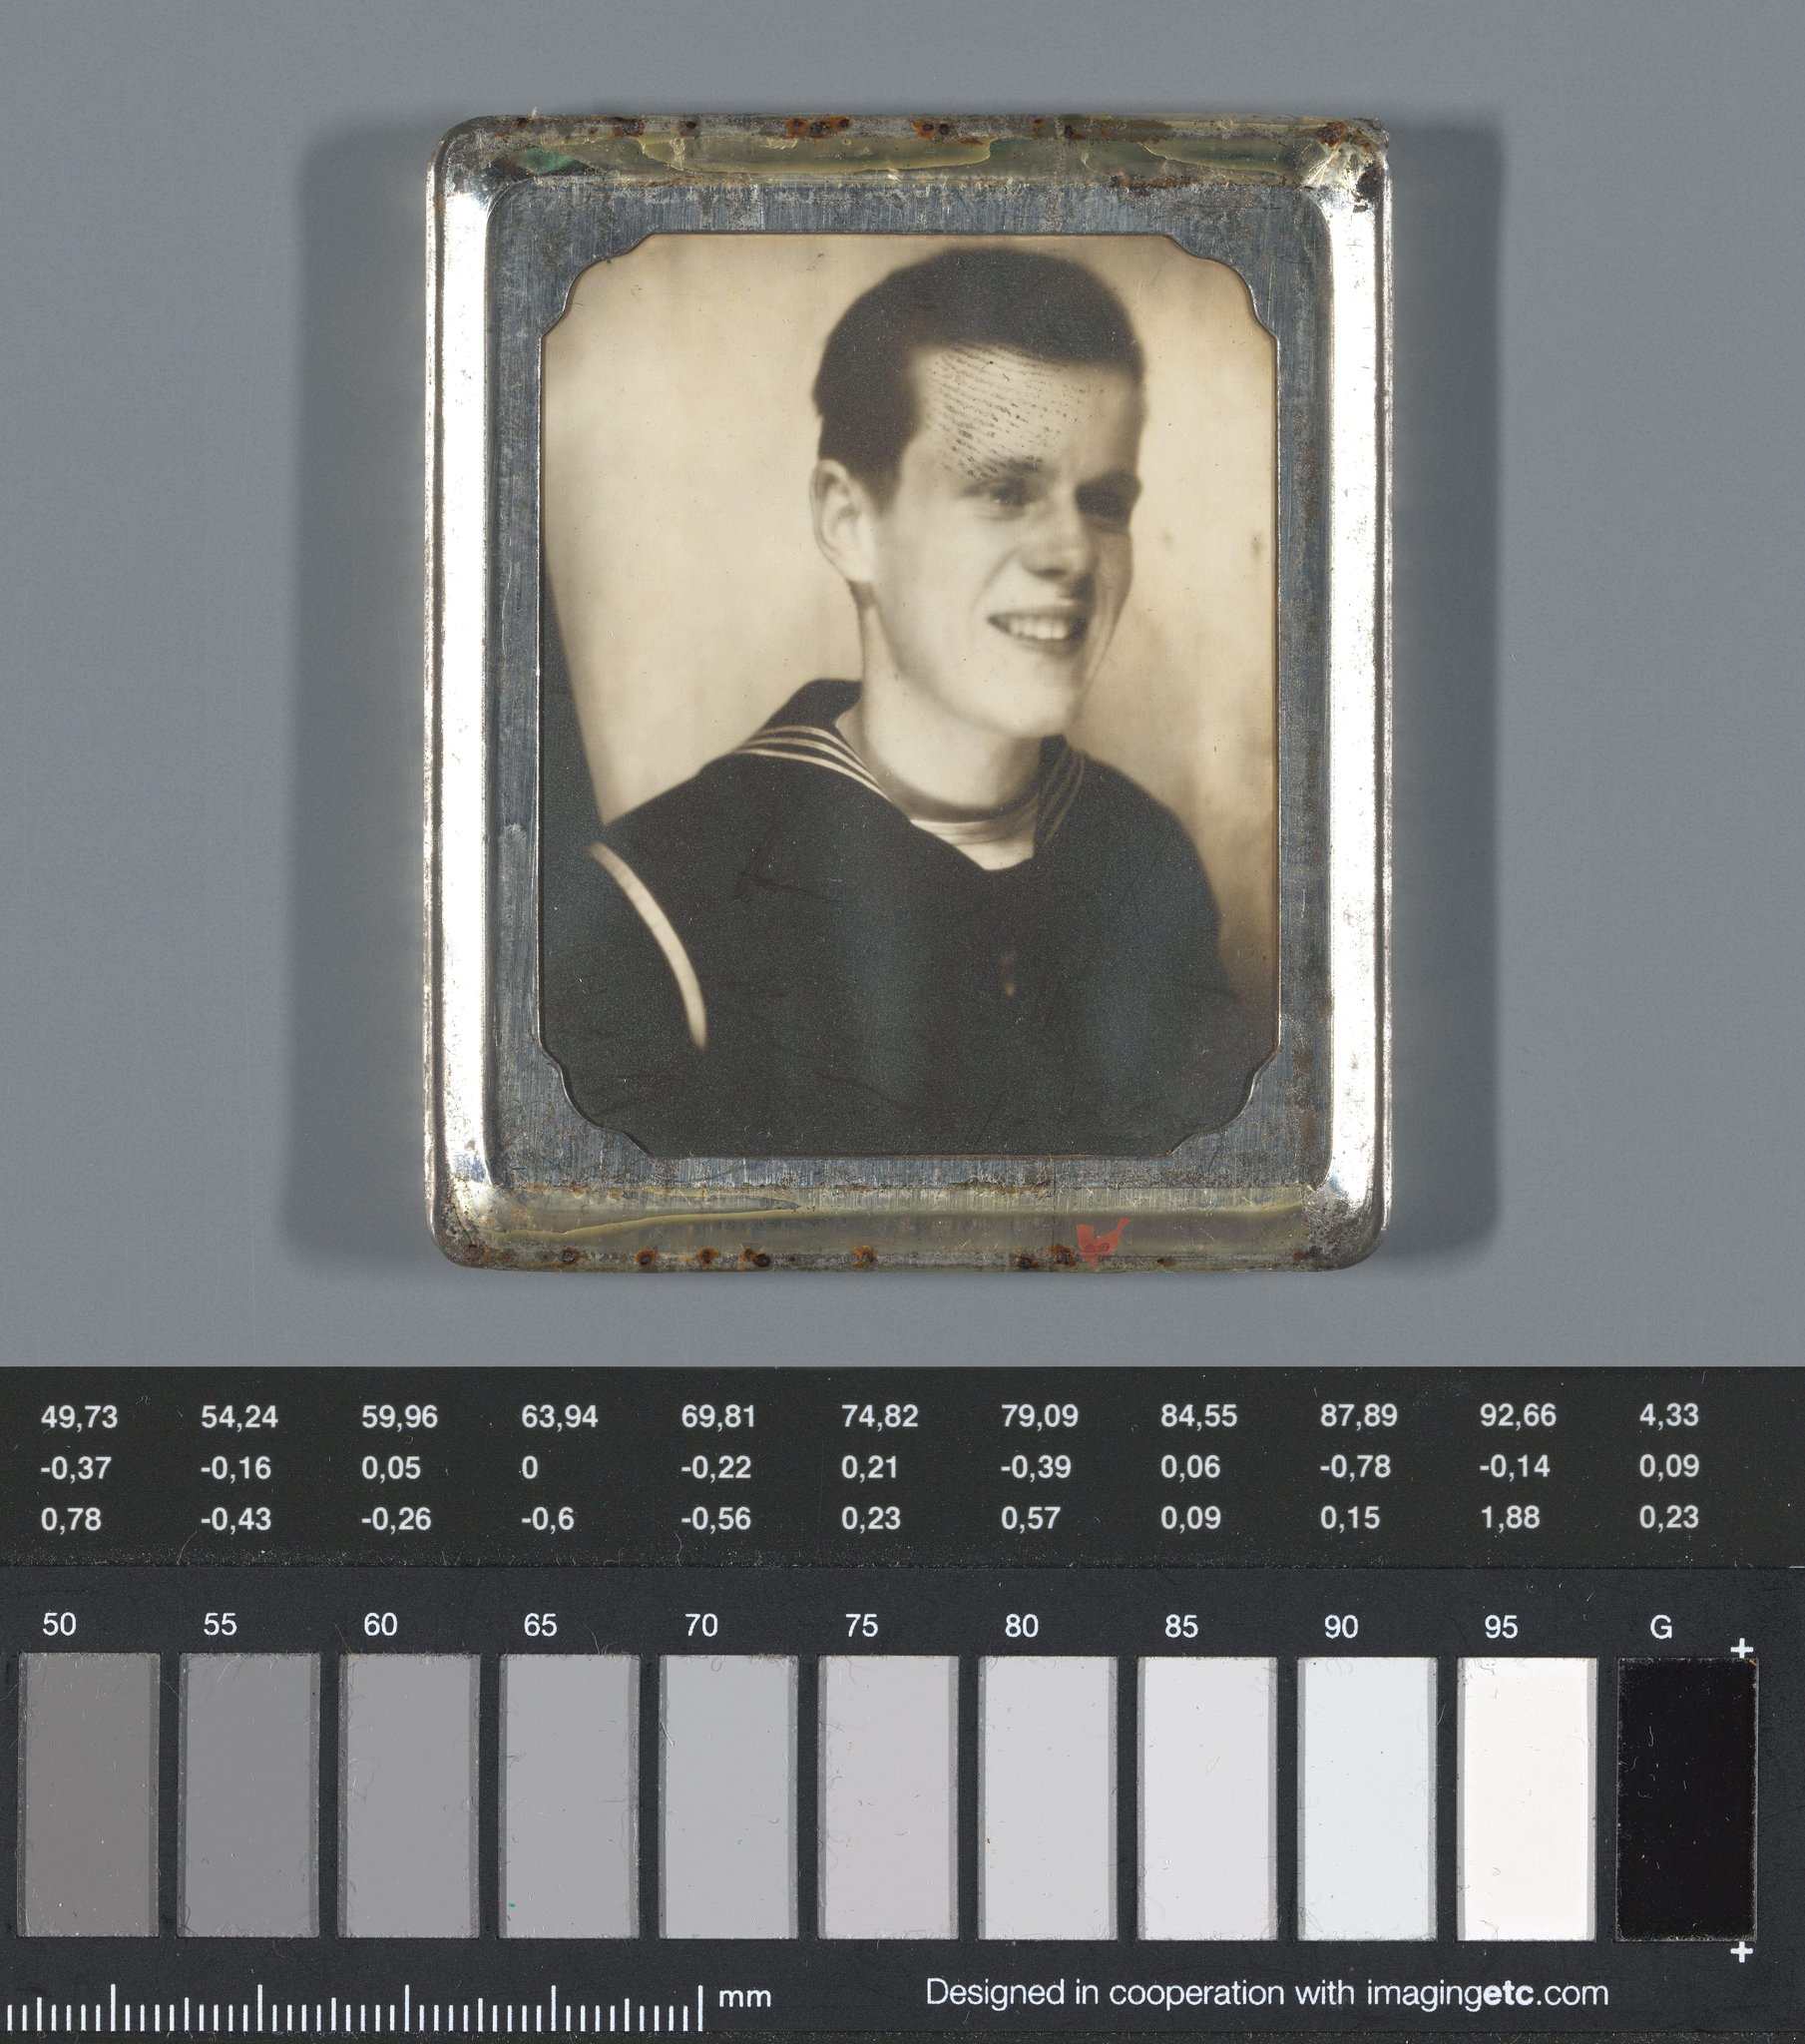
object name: photograph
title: William Swanson, matroos, Newport, R.I., 1944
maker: Anonymous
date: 1944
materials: photographic support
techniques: gelatin silver print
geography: united states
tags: william swanson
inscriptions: inscription: ‘IDENTIFICATION / NAME [op RP-F-2022-57-7 ingevuld maar onleesbaar] / Street / City [in pen: Newport, R.I.] / EMPLOYED BY [op RP-F-2022-57-7 ingevuld maar onleesbaar] / Mfg. by / POSITIVE PAPER / AND CHEMICAL CO., Inc. / 30 Clifton St., Newark, N. J.’